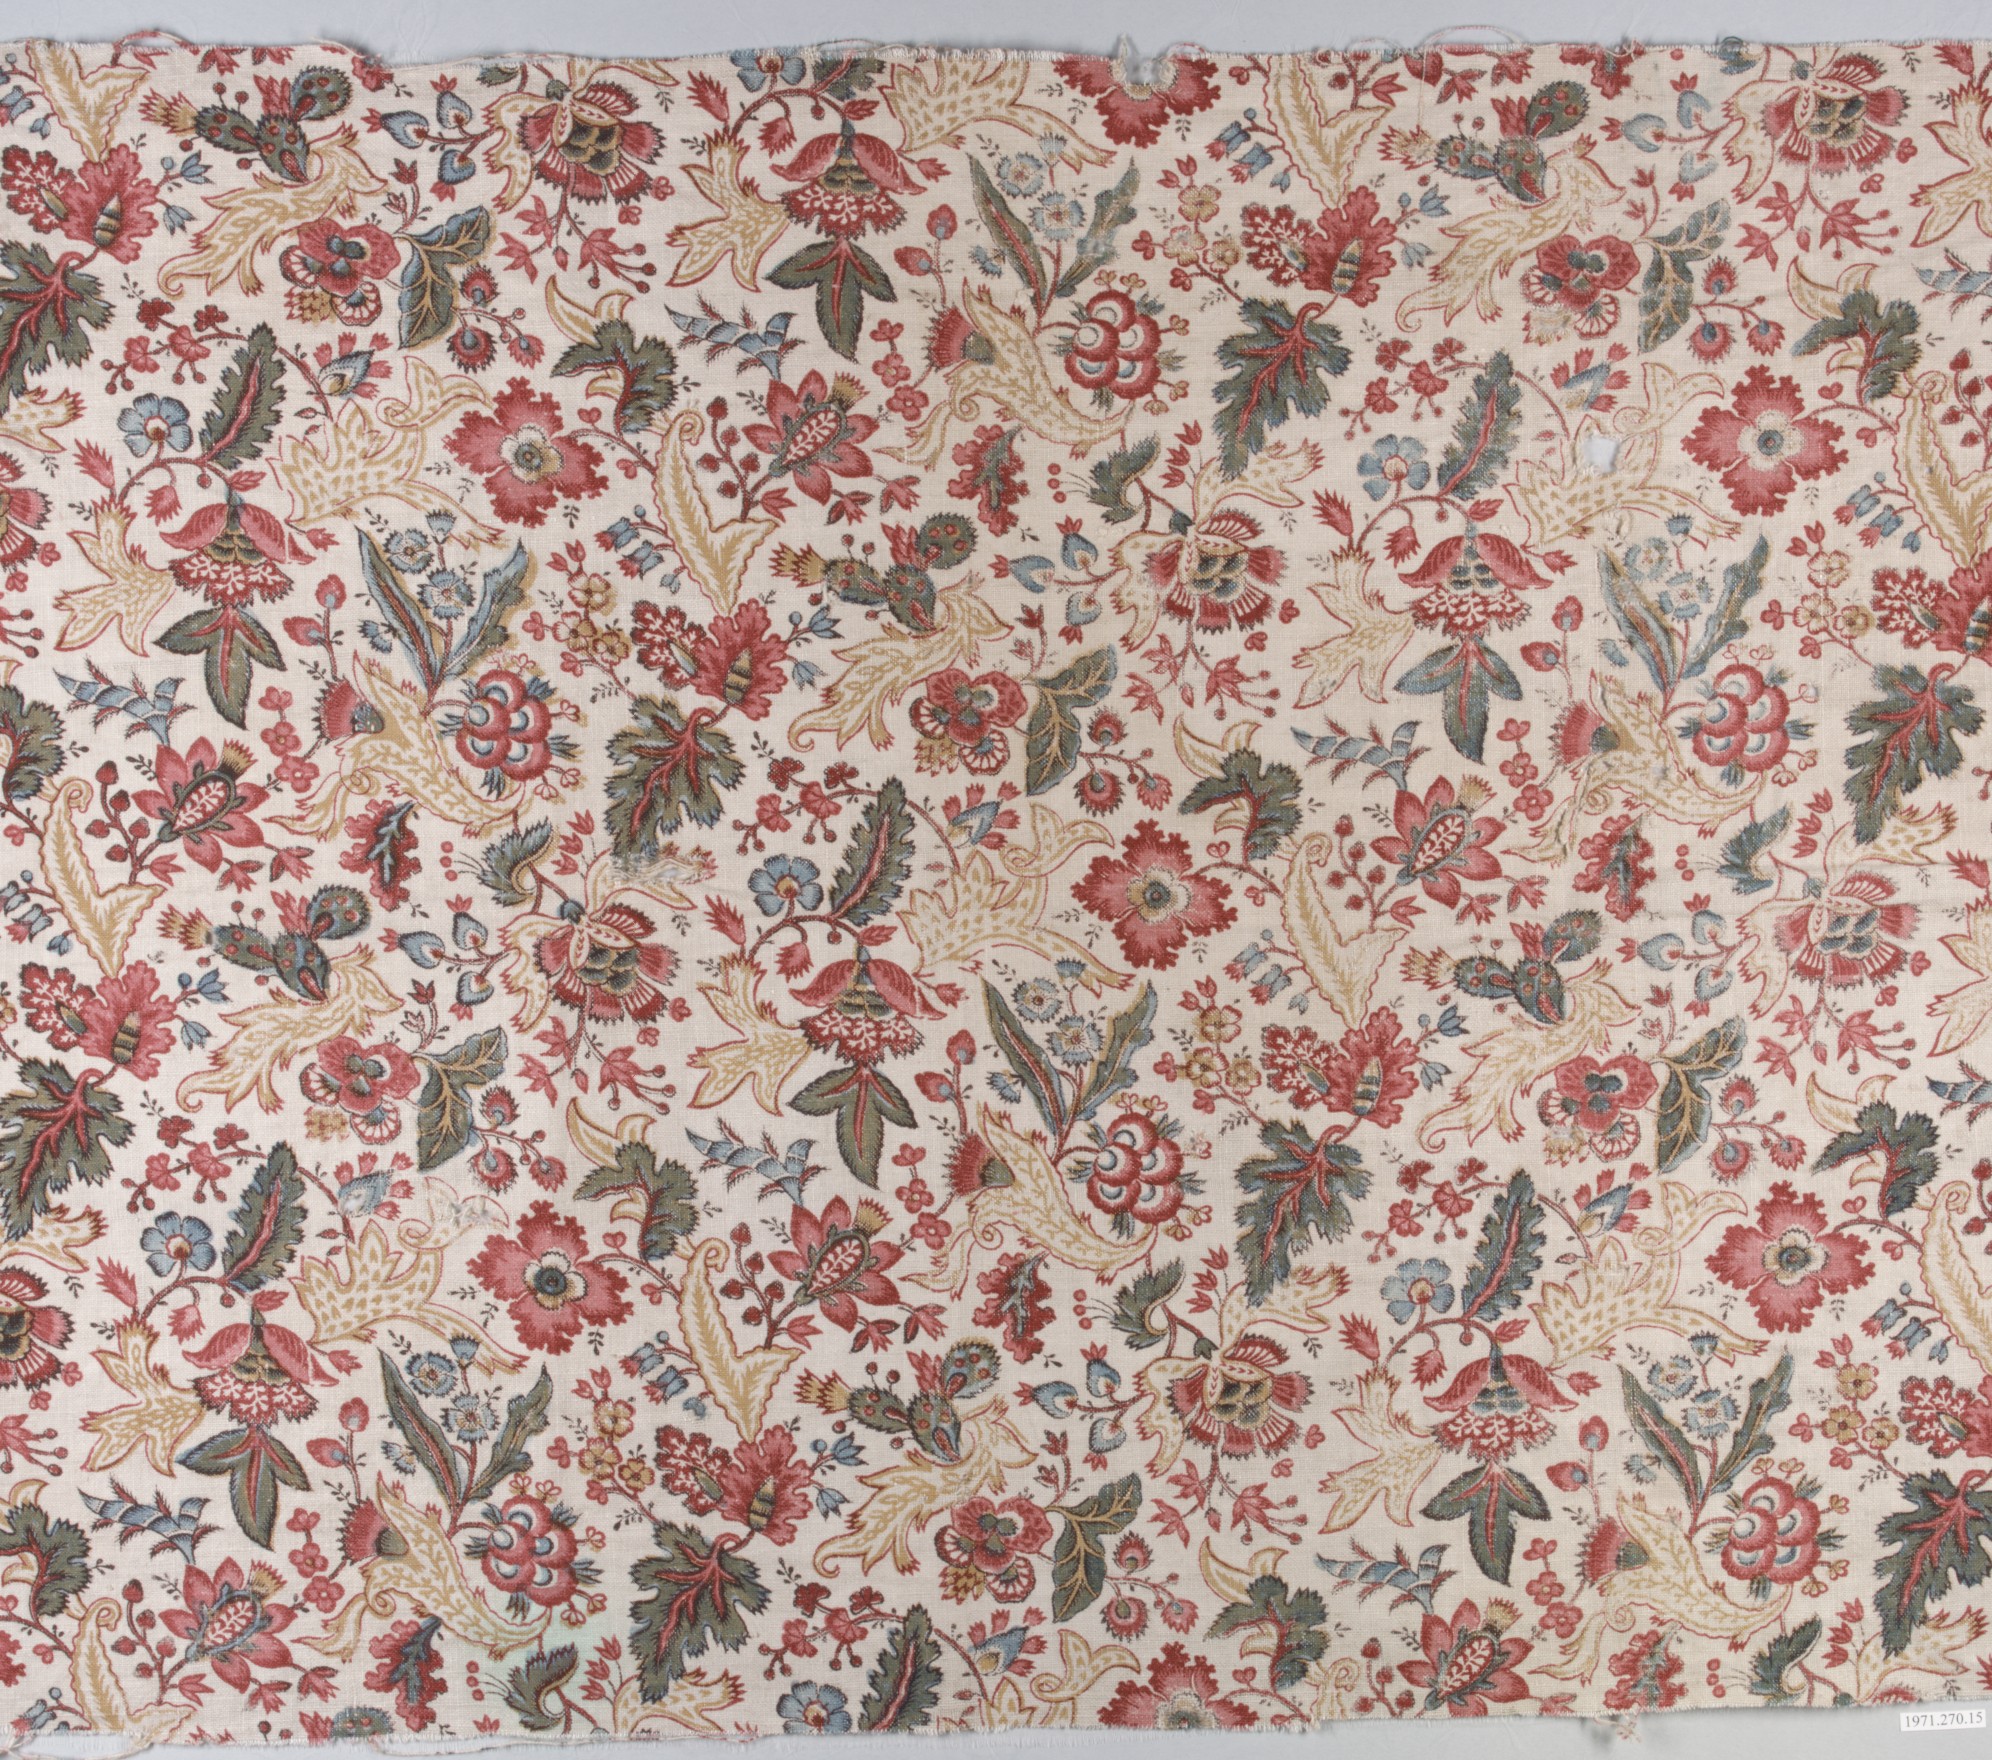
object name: piece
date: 1785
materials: cotton, linen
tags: flowers,leaves